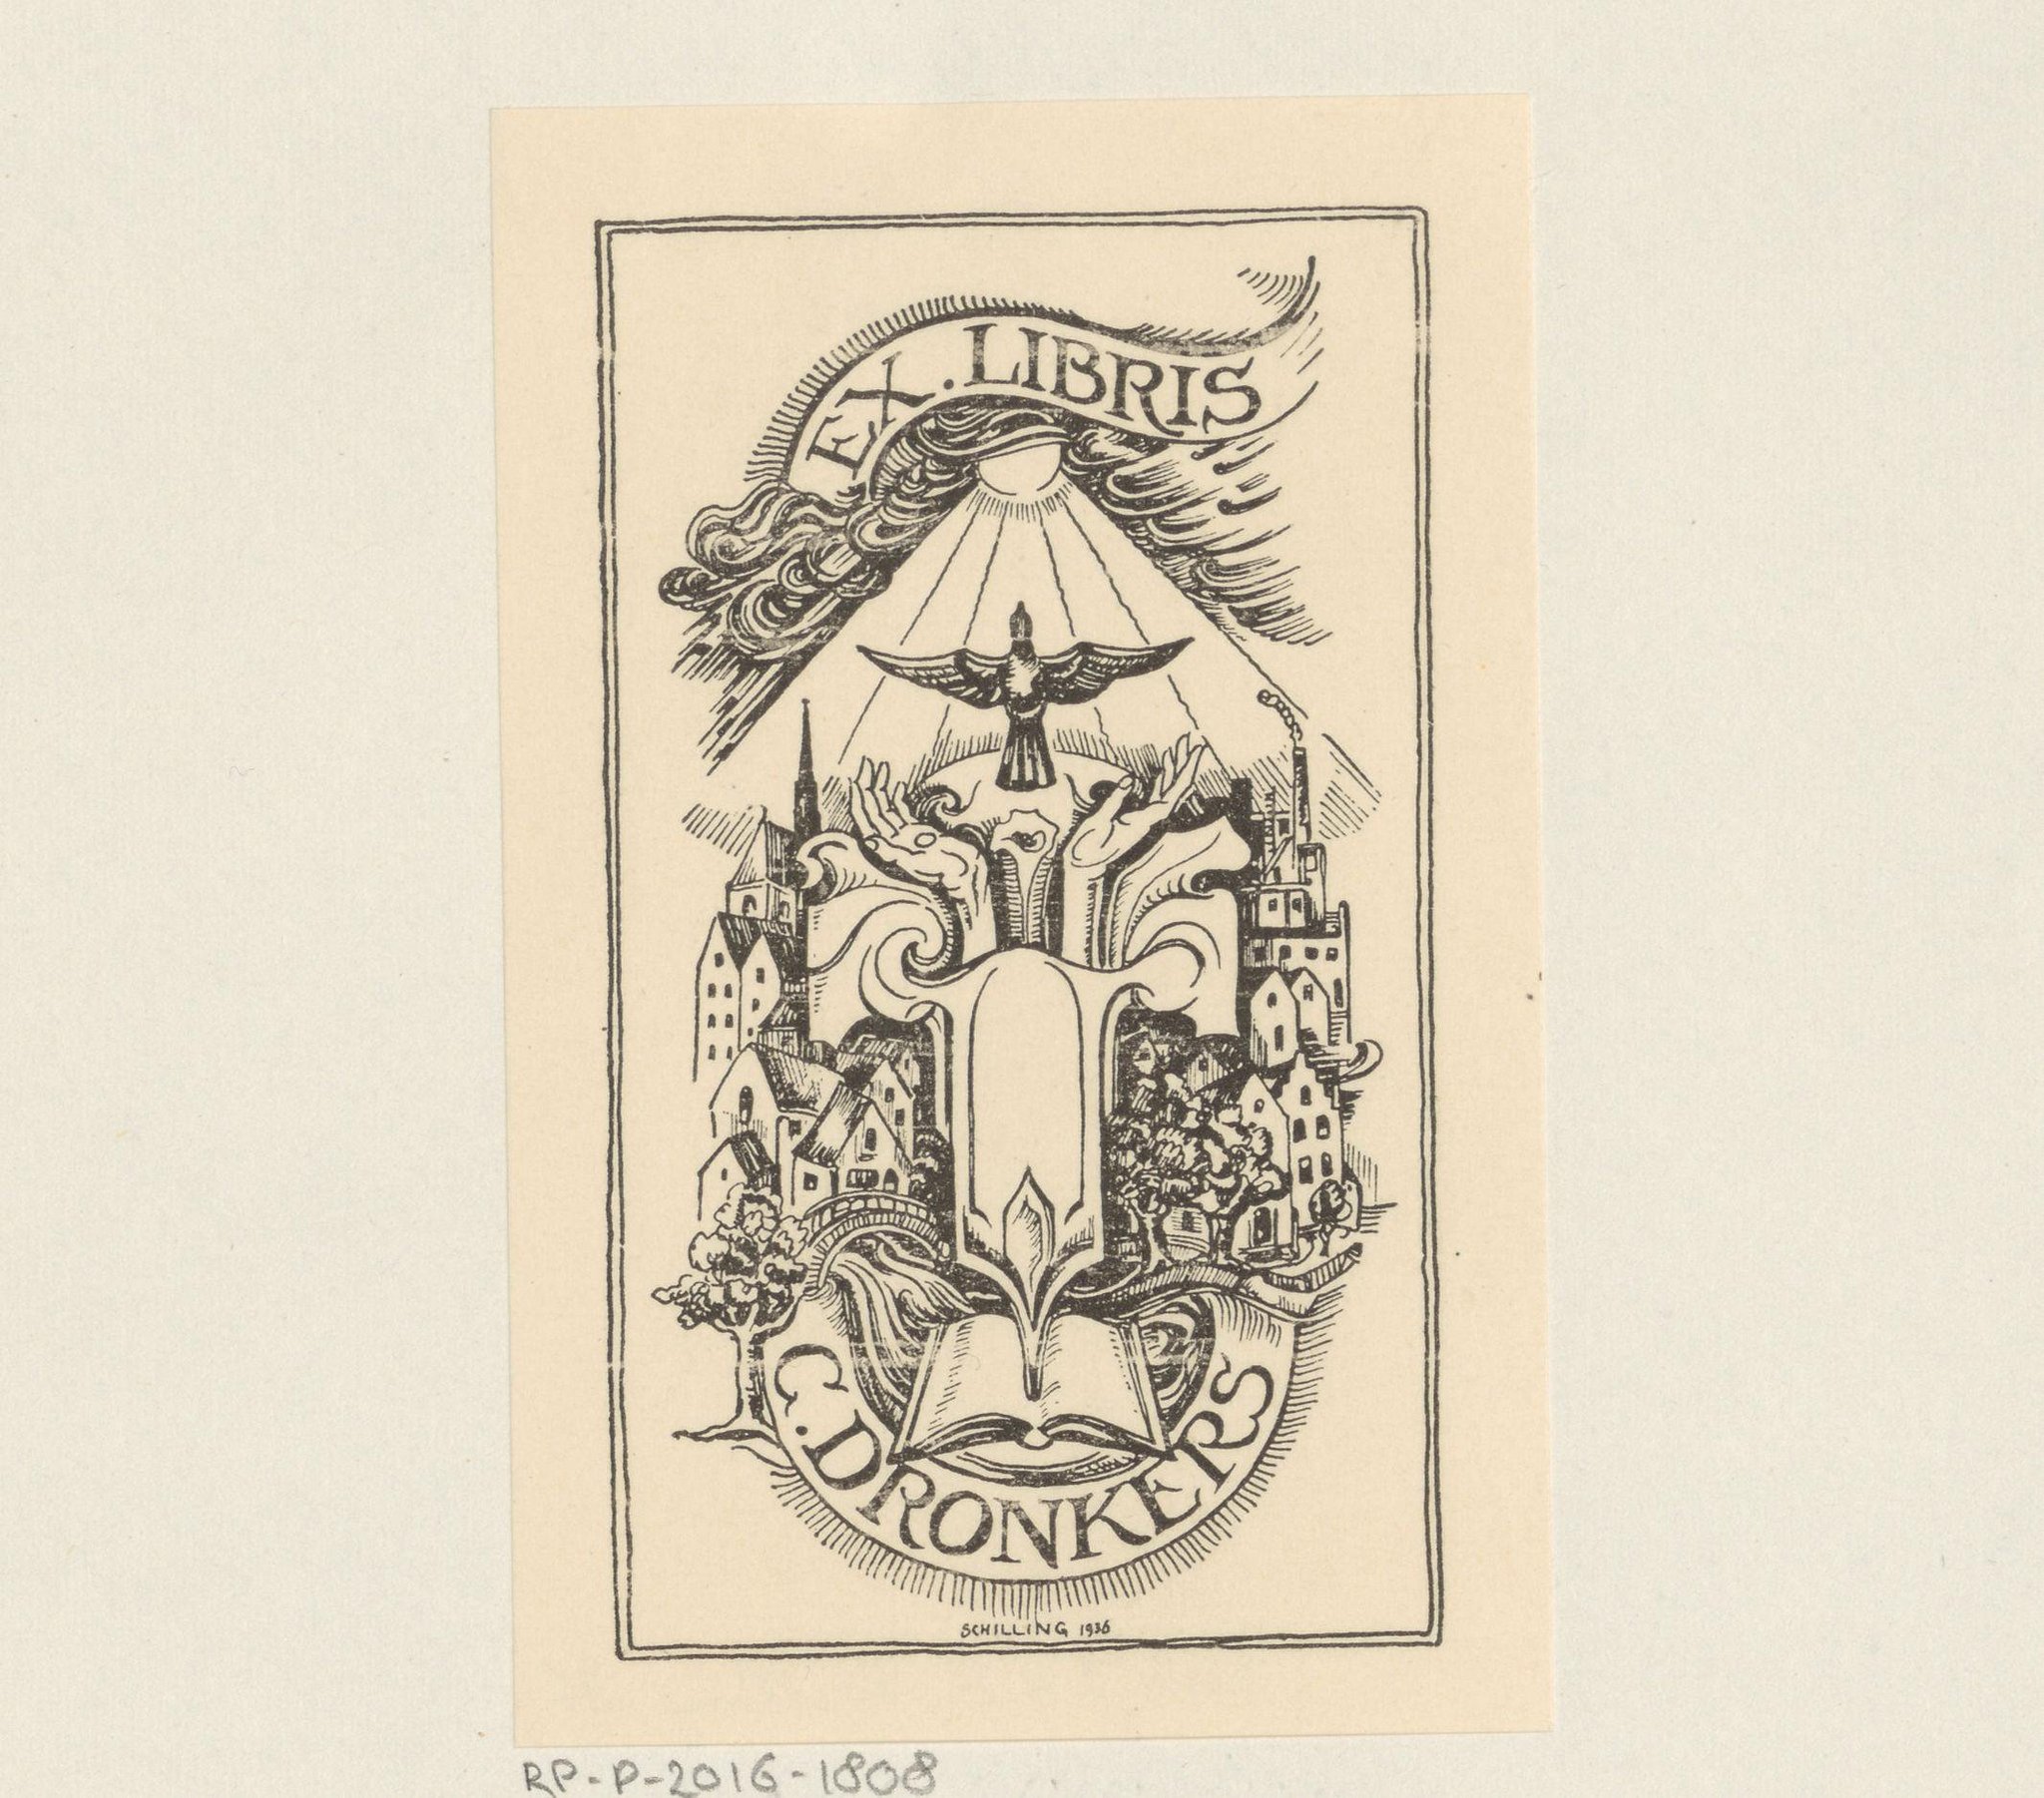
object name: bookplate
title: Ex libris van C. Dronkers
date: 1936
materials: paper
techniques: printing block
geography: netherlands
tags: book, the holy ghost, prospect of city, town panorama, silhouette of city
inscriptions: inscription: ‘Ontw. J.H.E. Schilling '36’